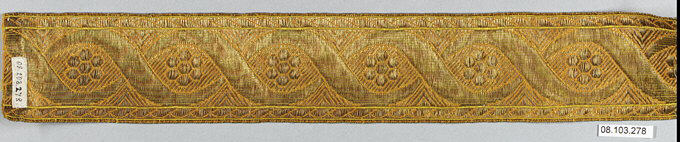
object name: galloon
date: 1801-1833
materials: metal thread, silk